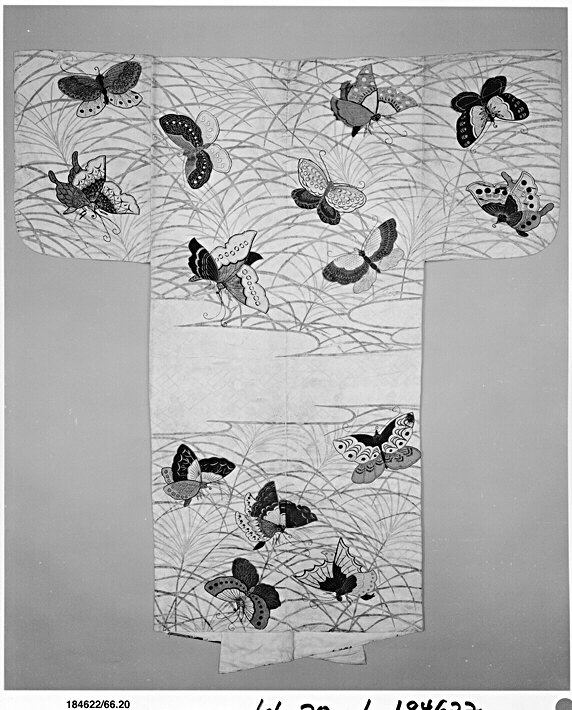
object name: noh robe nuihaku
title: Noh robe (Nuihaku) with Design of Butterflies and Miscanthus Grass in Mist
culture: japanese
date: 1601-1700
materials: gold, silk, silver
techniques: damask, embroidery, weave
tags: costumes,butterflies